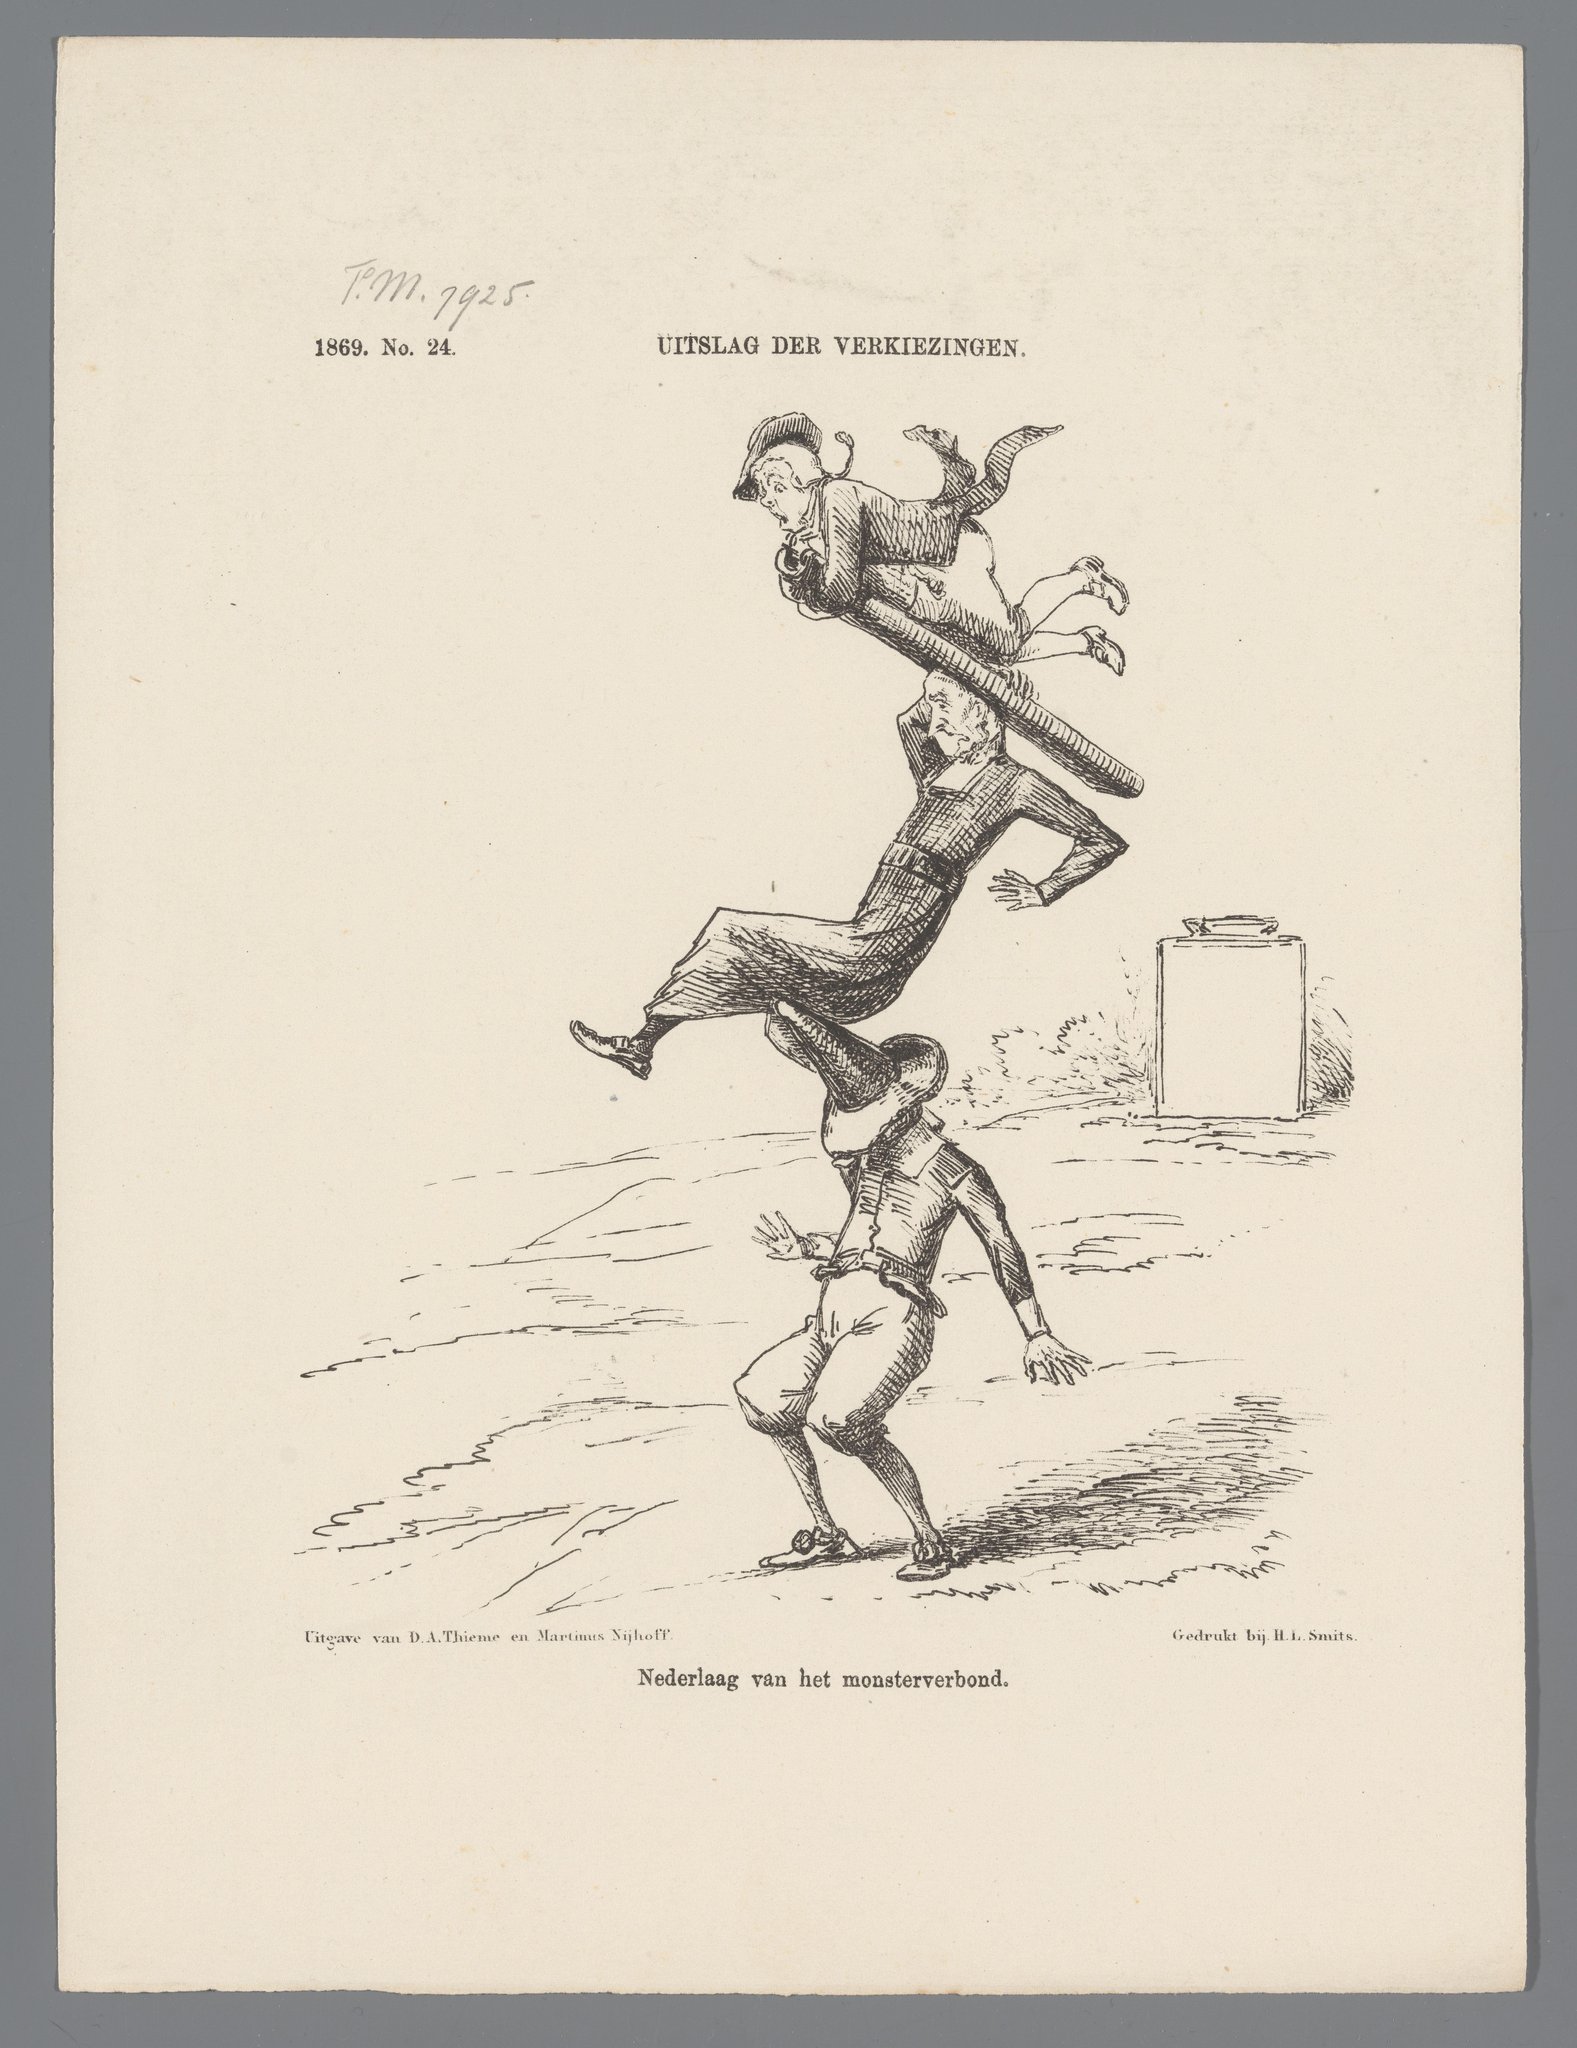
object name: cartoon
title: Spotprent op de nederlaag van de antirevolutionairen bij de verkiezingen, 1869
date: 1869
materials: paper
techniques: lithograph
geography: netherlands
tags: voting, election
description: Spotprent op de nederlaag van de antirevolutionairen bij de verkiezingen. De zuil van drie op elkaar staande personen (conservatief, ultramontijn en antirevolutionair) valt om. Plaat verschenen bij het weekblad De Nederlandsche Spectator, nr. 24, 1869.